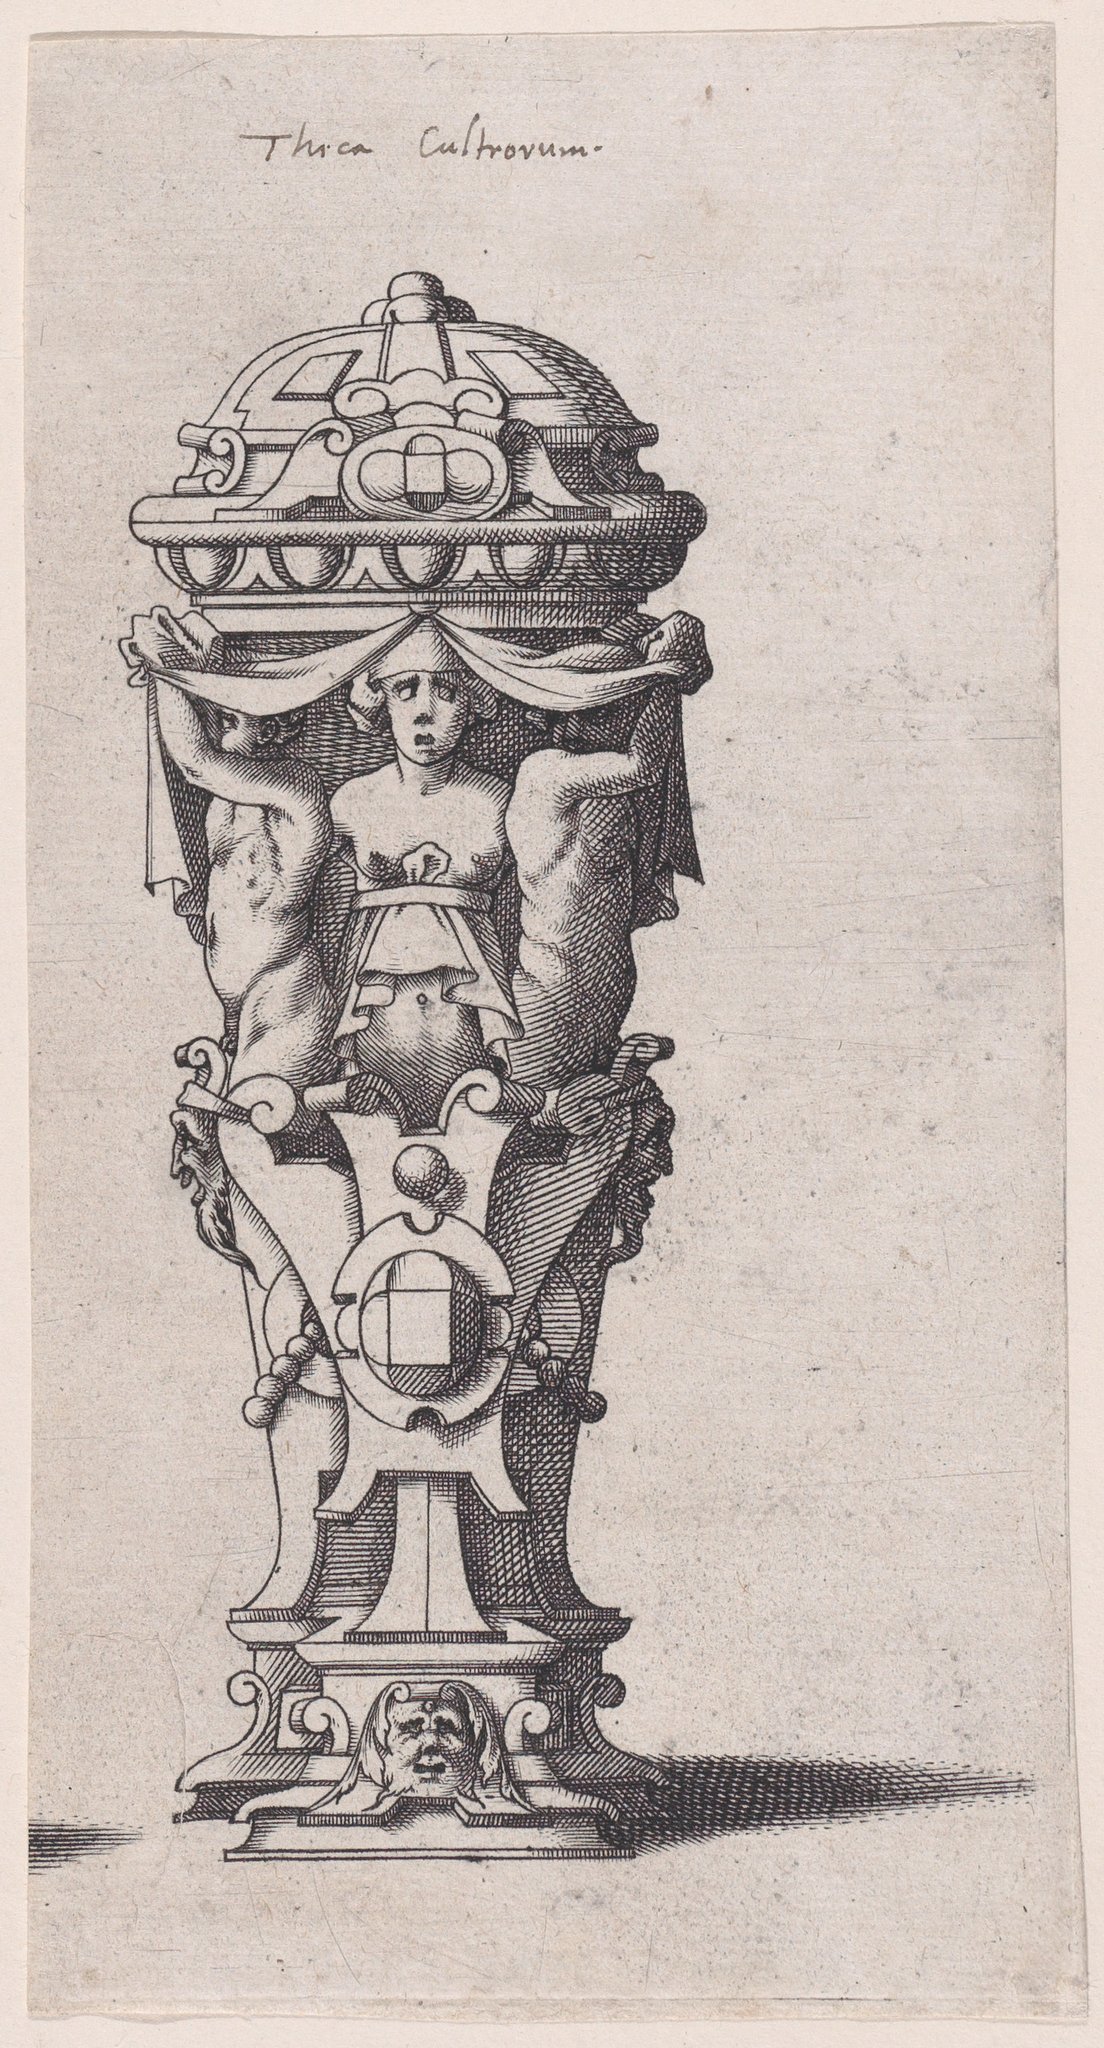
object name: print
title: Container with a Woman between Two Men (Nécessaire de table)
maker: rené boyvin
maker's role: artist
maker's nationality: french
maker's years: 1525-1598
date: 1525-1600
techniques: engraving